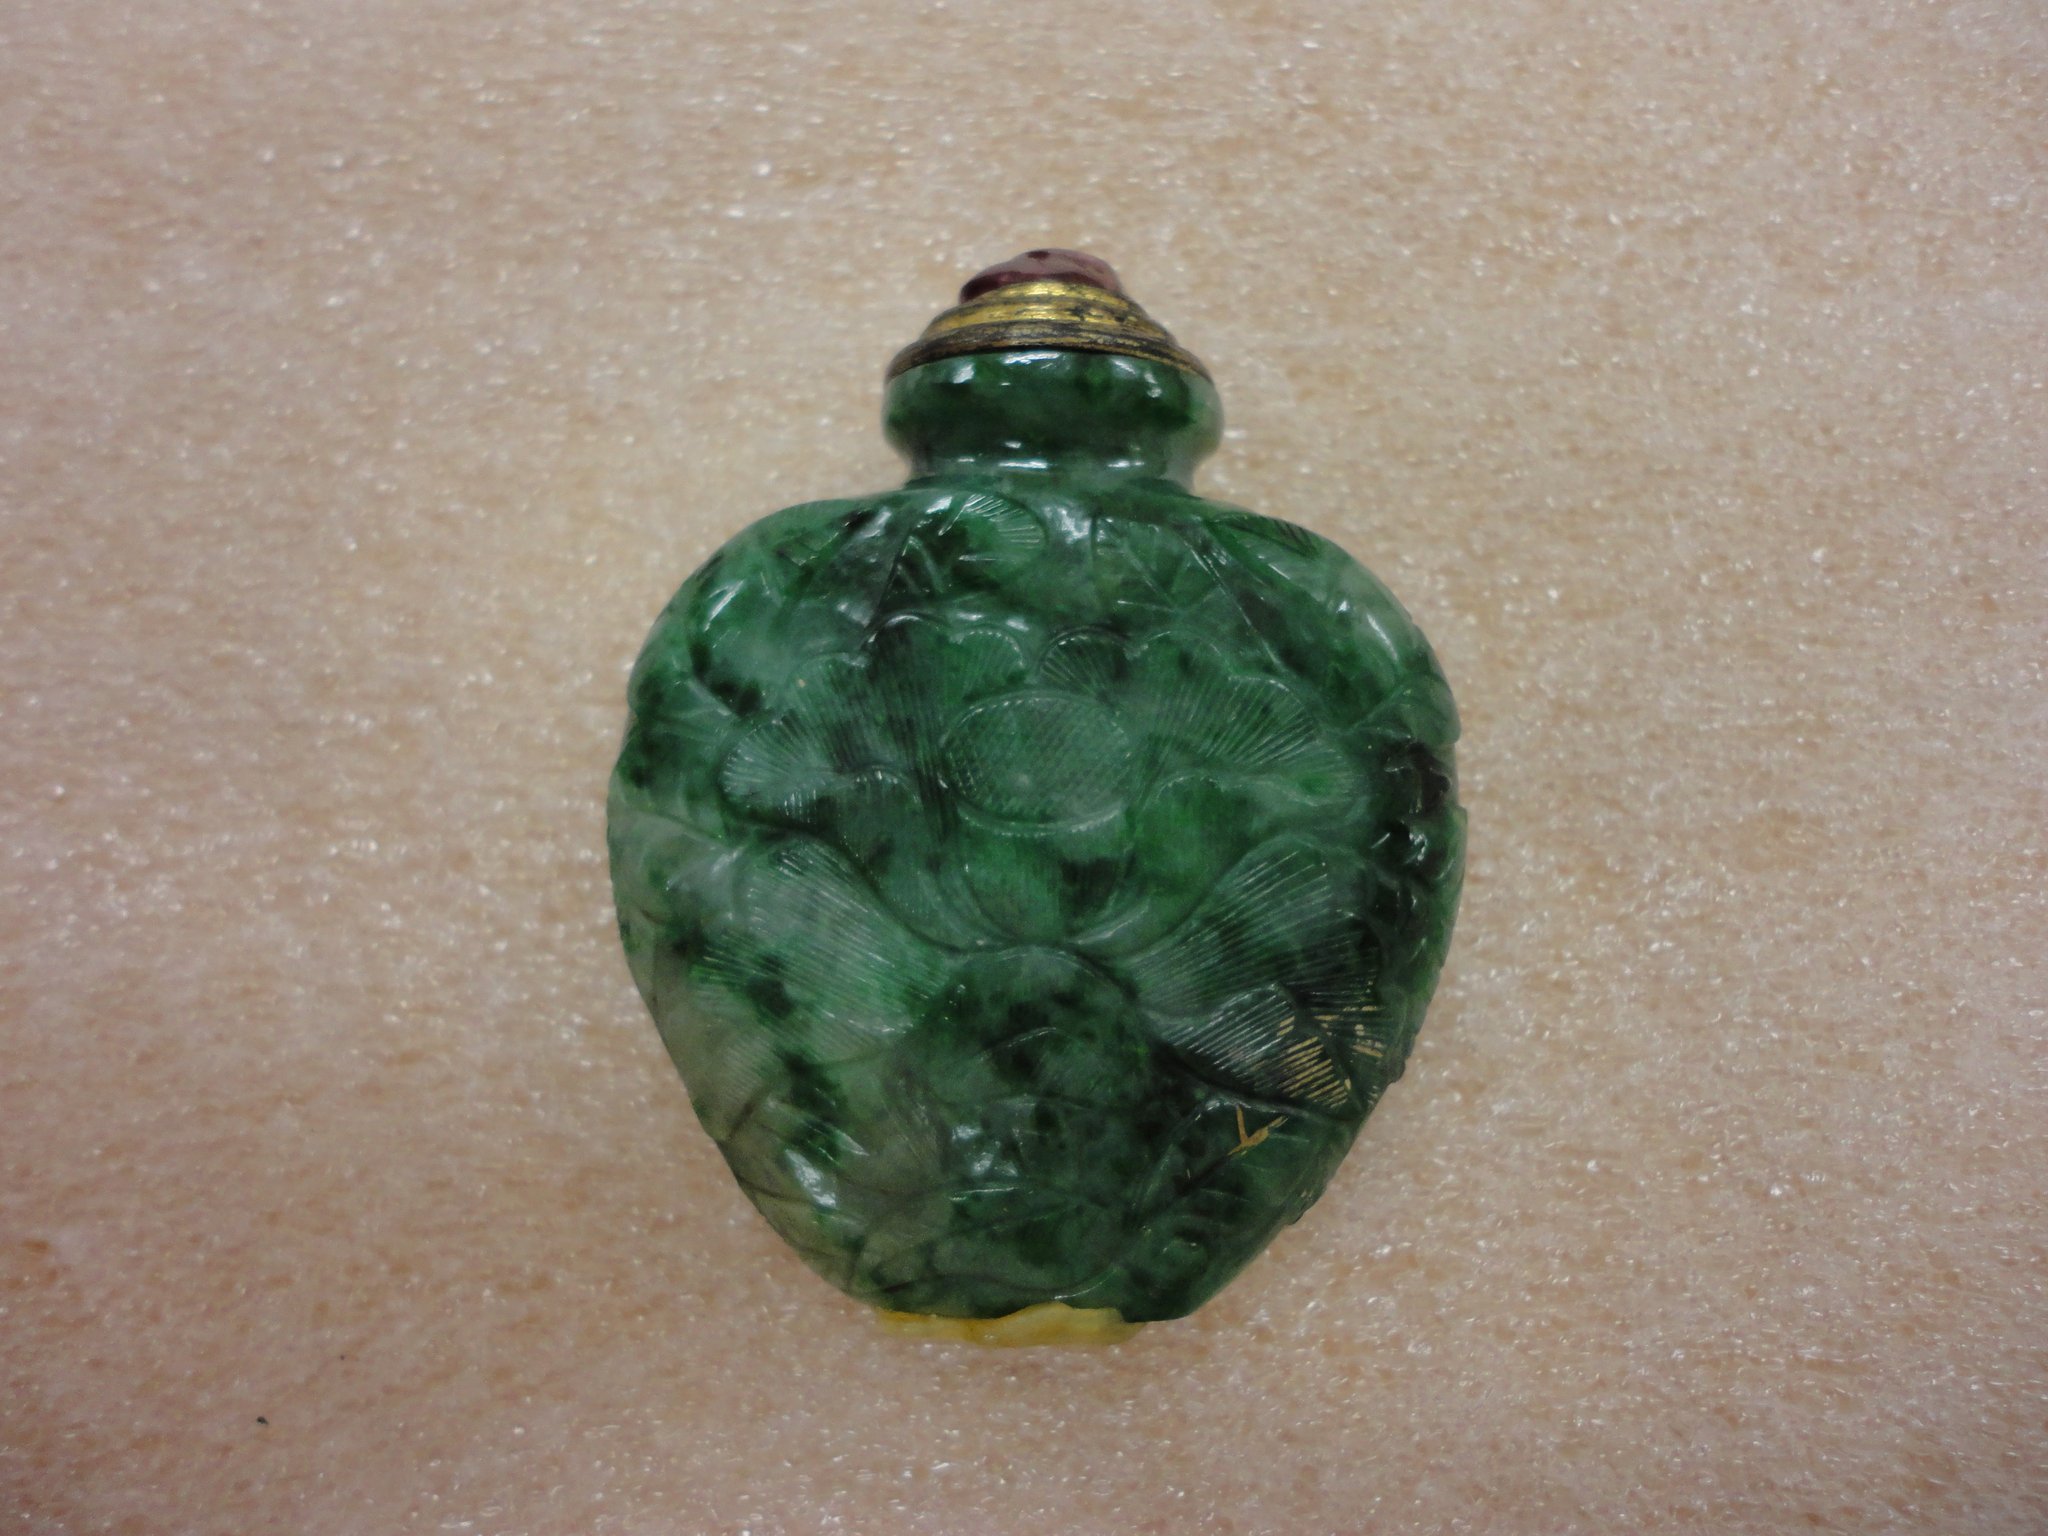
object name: snuff bottle with stopper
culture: chinese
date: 1796-1875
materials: jade